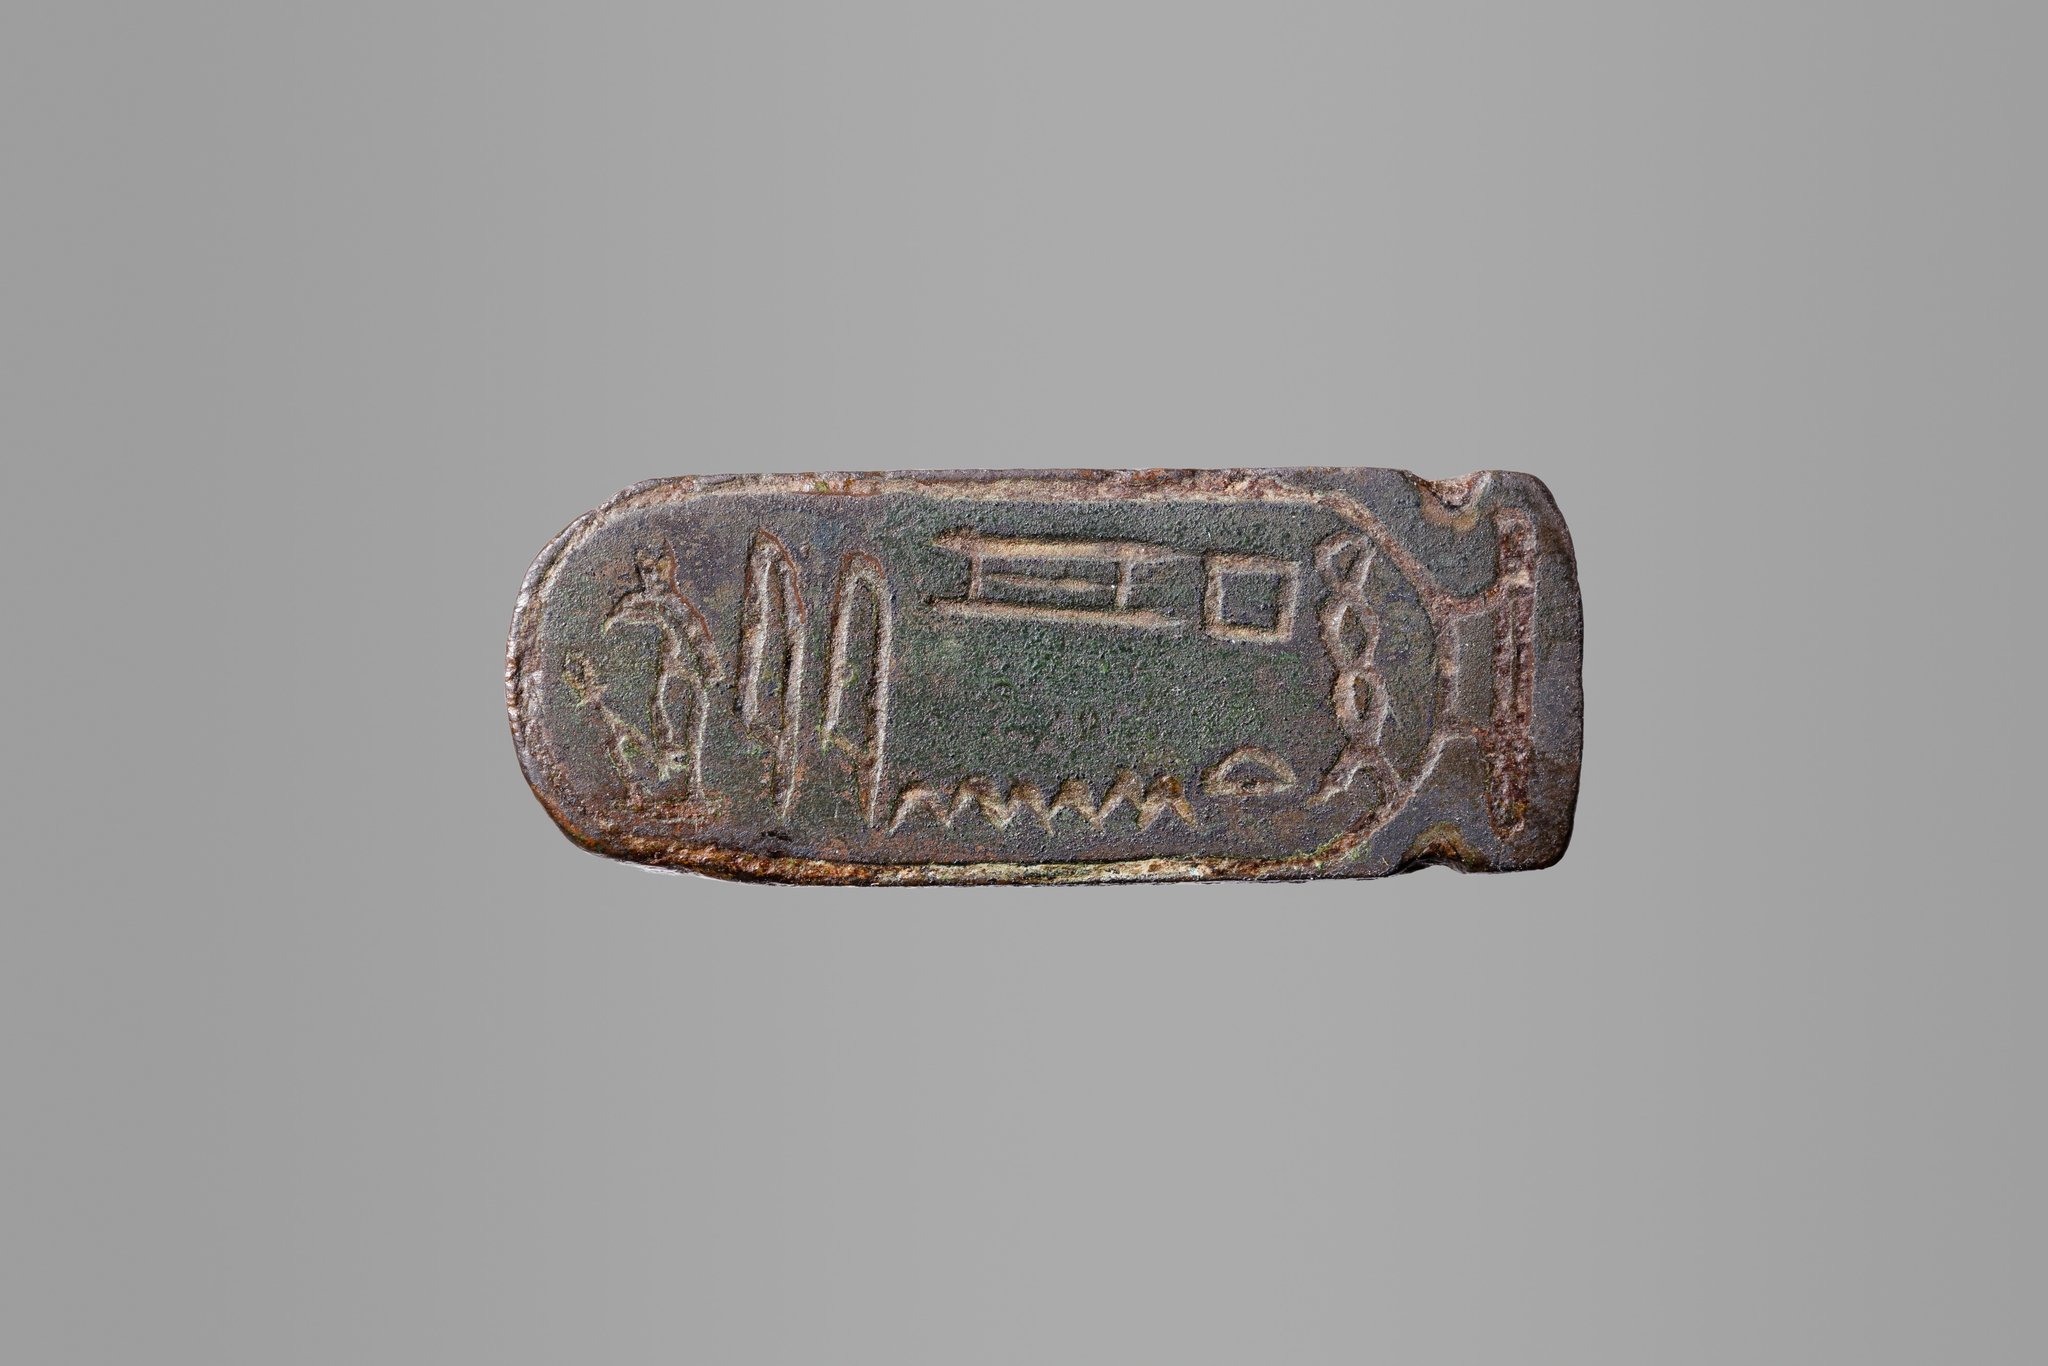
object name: ring, seti ii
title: Ring of Seti II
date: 1295-1070 BCE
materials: bronze, copper alloy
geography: egypt